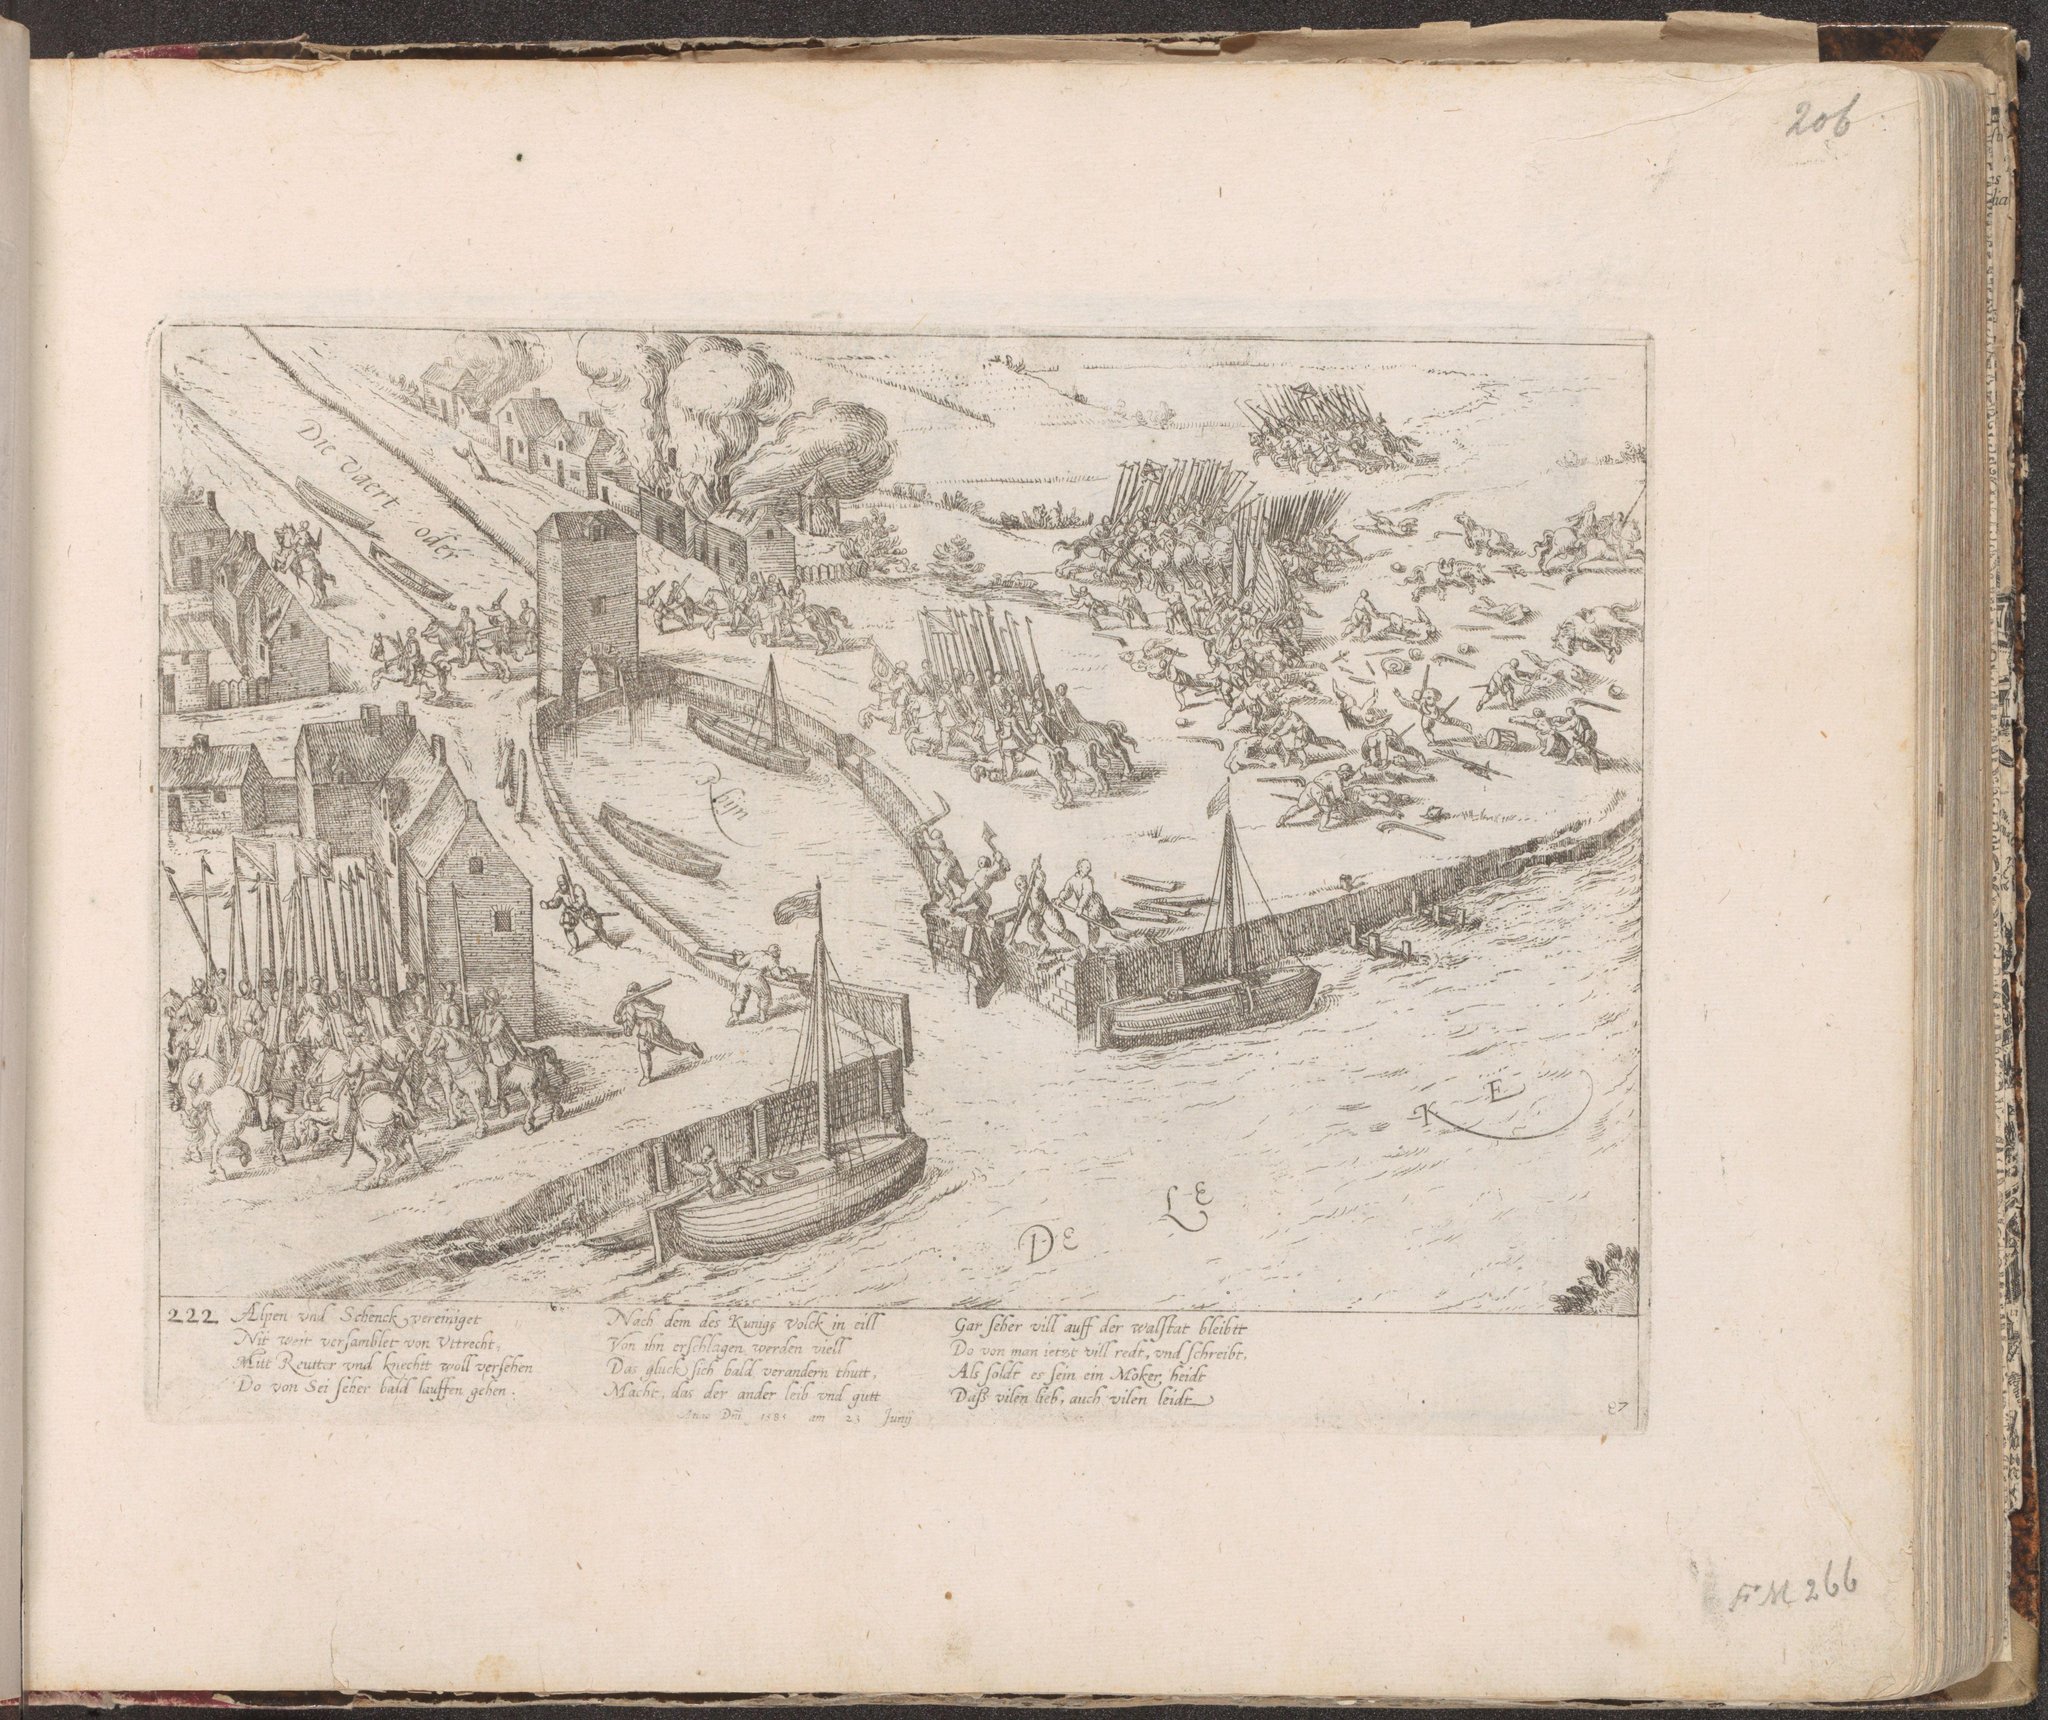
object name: history print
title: Gevecht bij de sluis van Vreeswijk, 1585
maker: frans hogenberg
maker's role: print maker, publisher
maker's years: 1538-1590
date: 1587-1591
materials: paper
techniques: etching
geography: cologne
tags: battle (+ land forces)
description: Gevechten bij de Oude Sluis te Vreeswijk waar de Vaartse Rijn vanuit Utrecht in de Lek uitkomt, 23 juni 1585. De huizen op de oostelijke oever van de Vaartsche Rijn in brand zijn gestoken. Op de voorgrond de Lek. Met onderschrift van 12 regels in het Duits. Linksonder genummerd: 222. De prent maakt deel uit van een album.